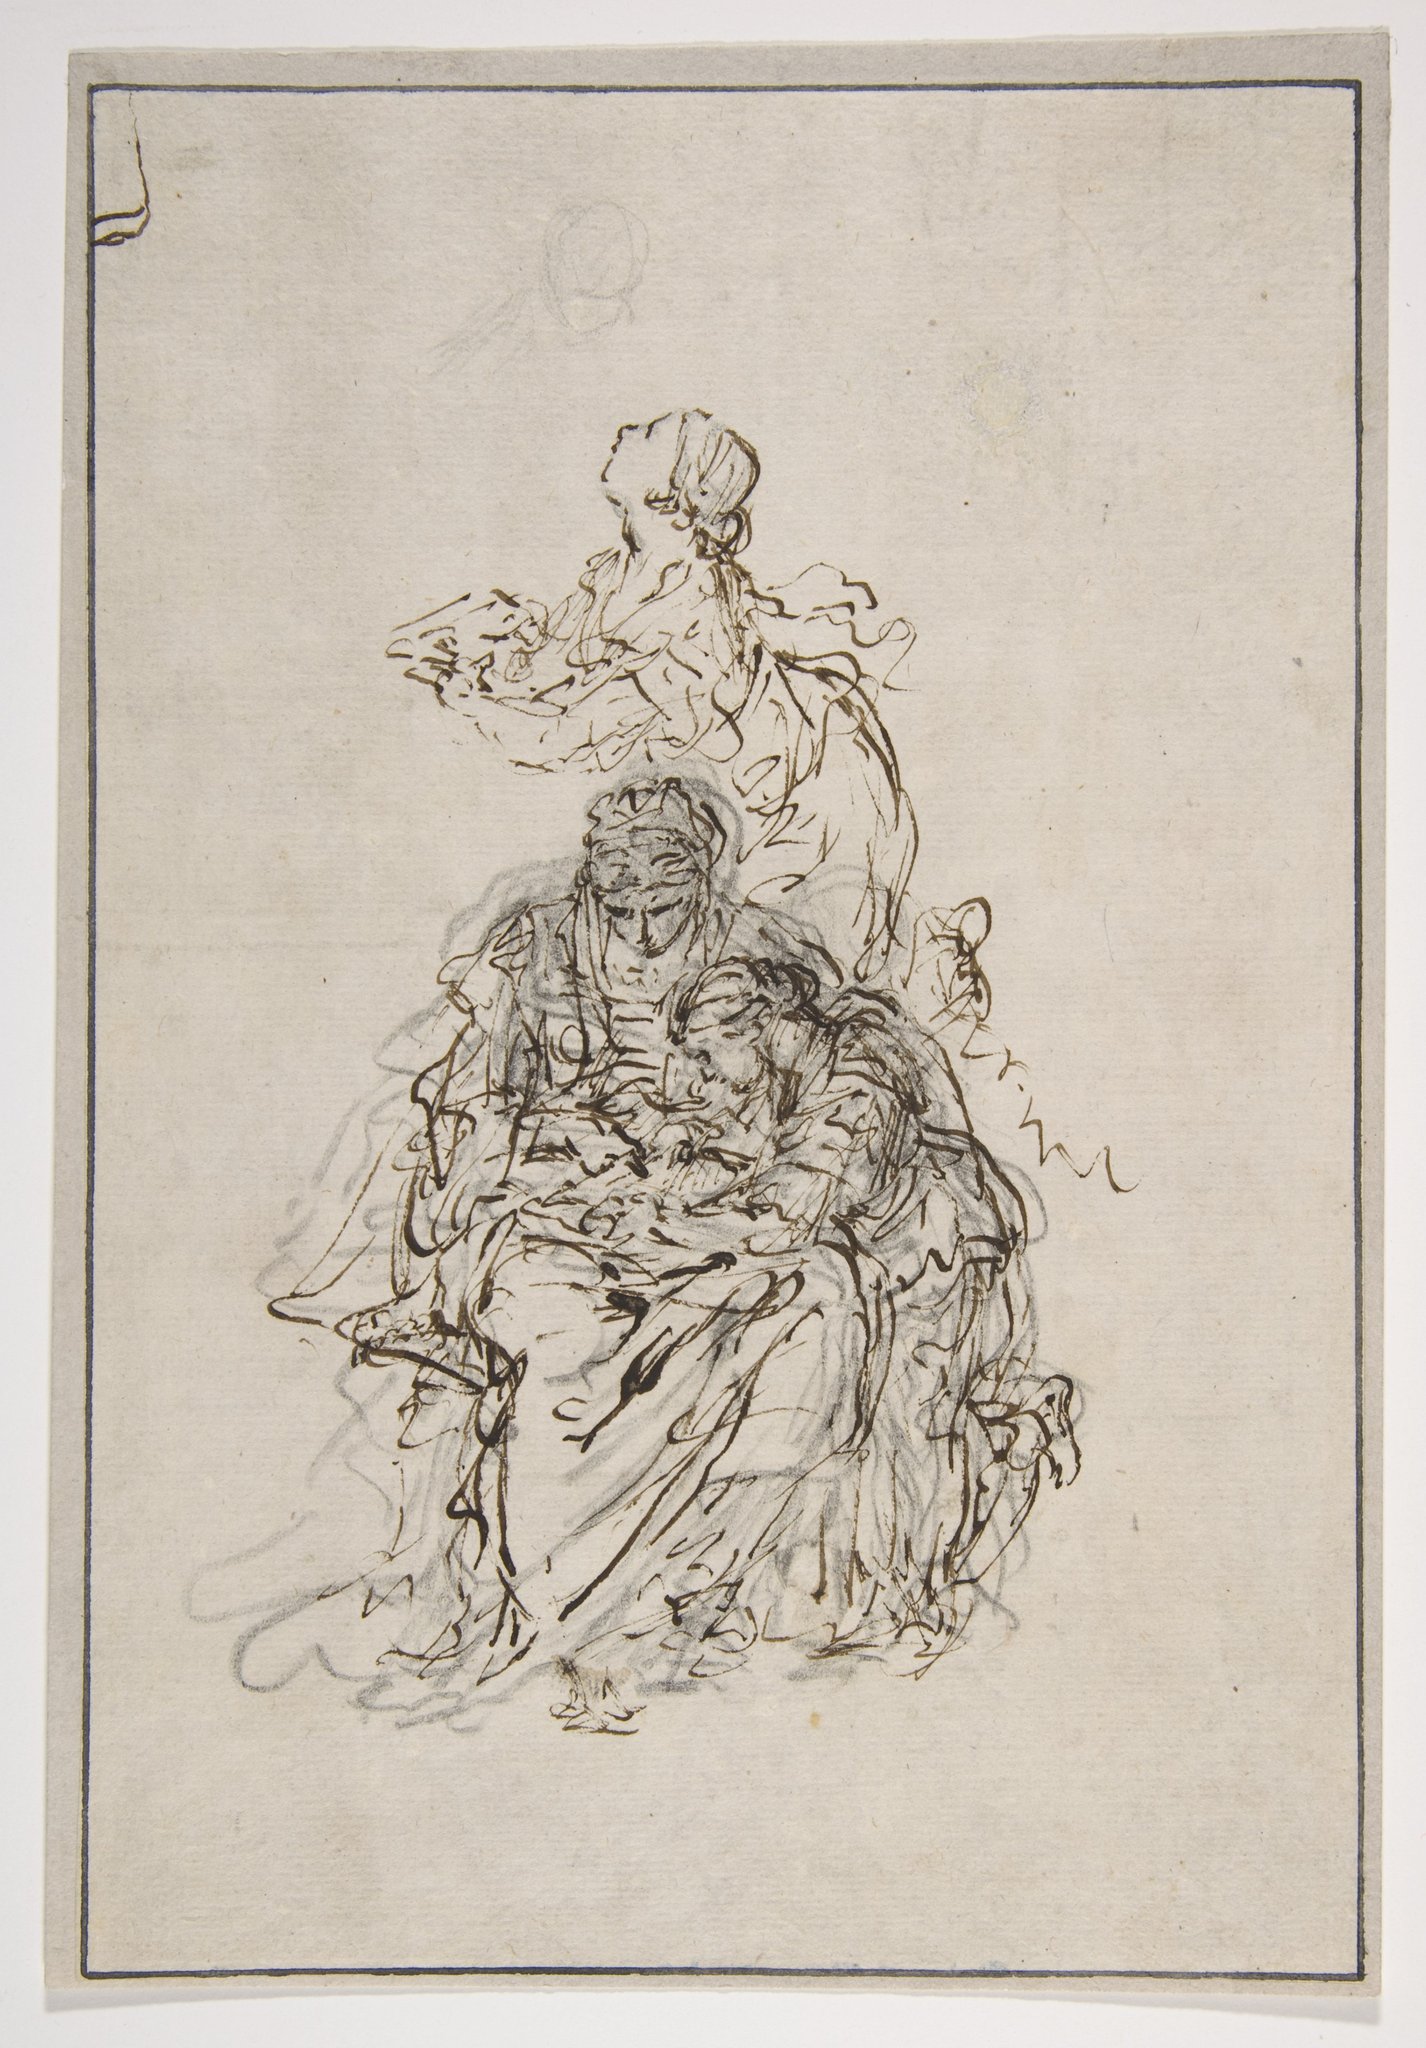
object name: drawing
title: Studies for an Education of the Virgin: Saint Anne Teaching the Virgin to Read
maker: sebastiano ricci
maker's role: artist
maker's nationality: italian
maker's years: 1659-1734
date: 1659-1734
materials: chalk, ink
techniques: pen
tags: reading,saint anne,virgin mary